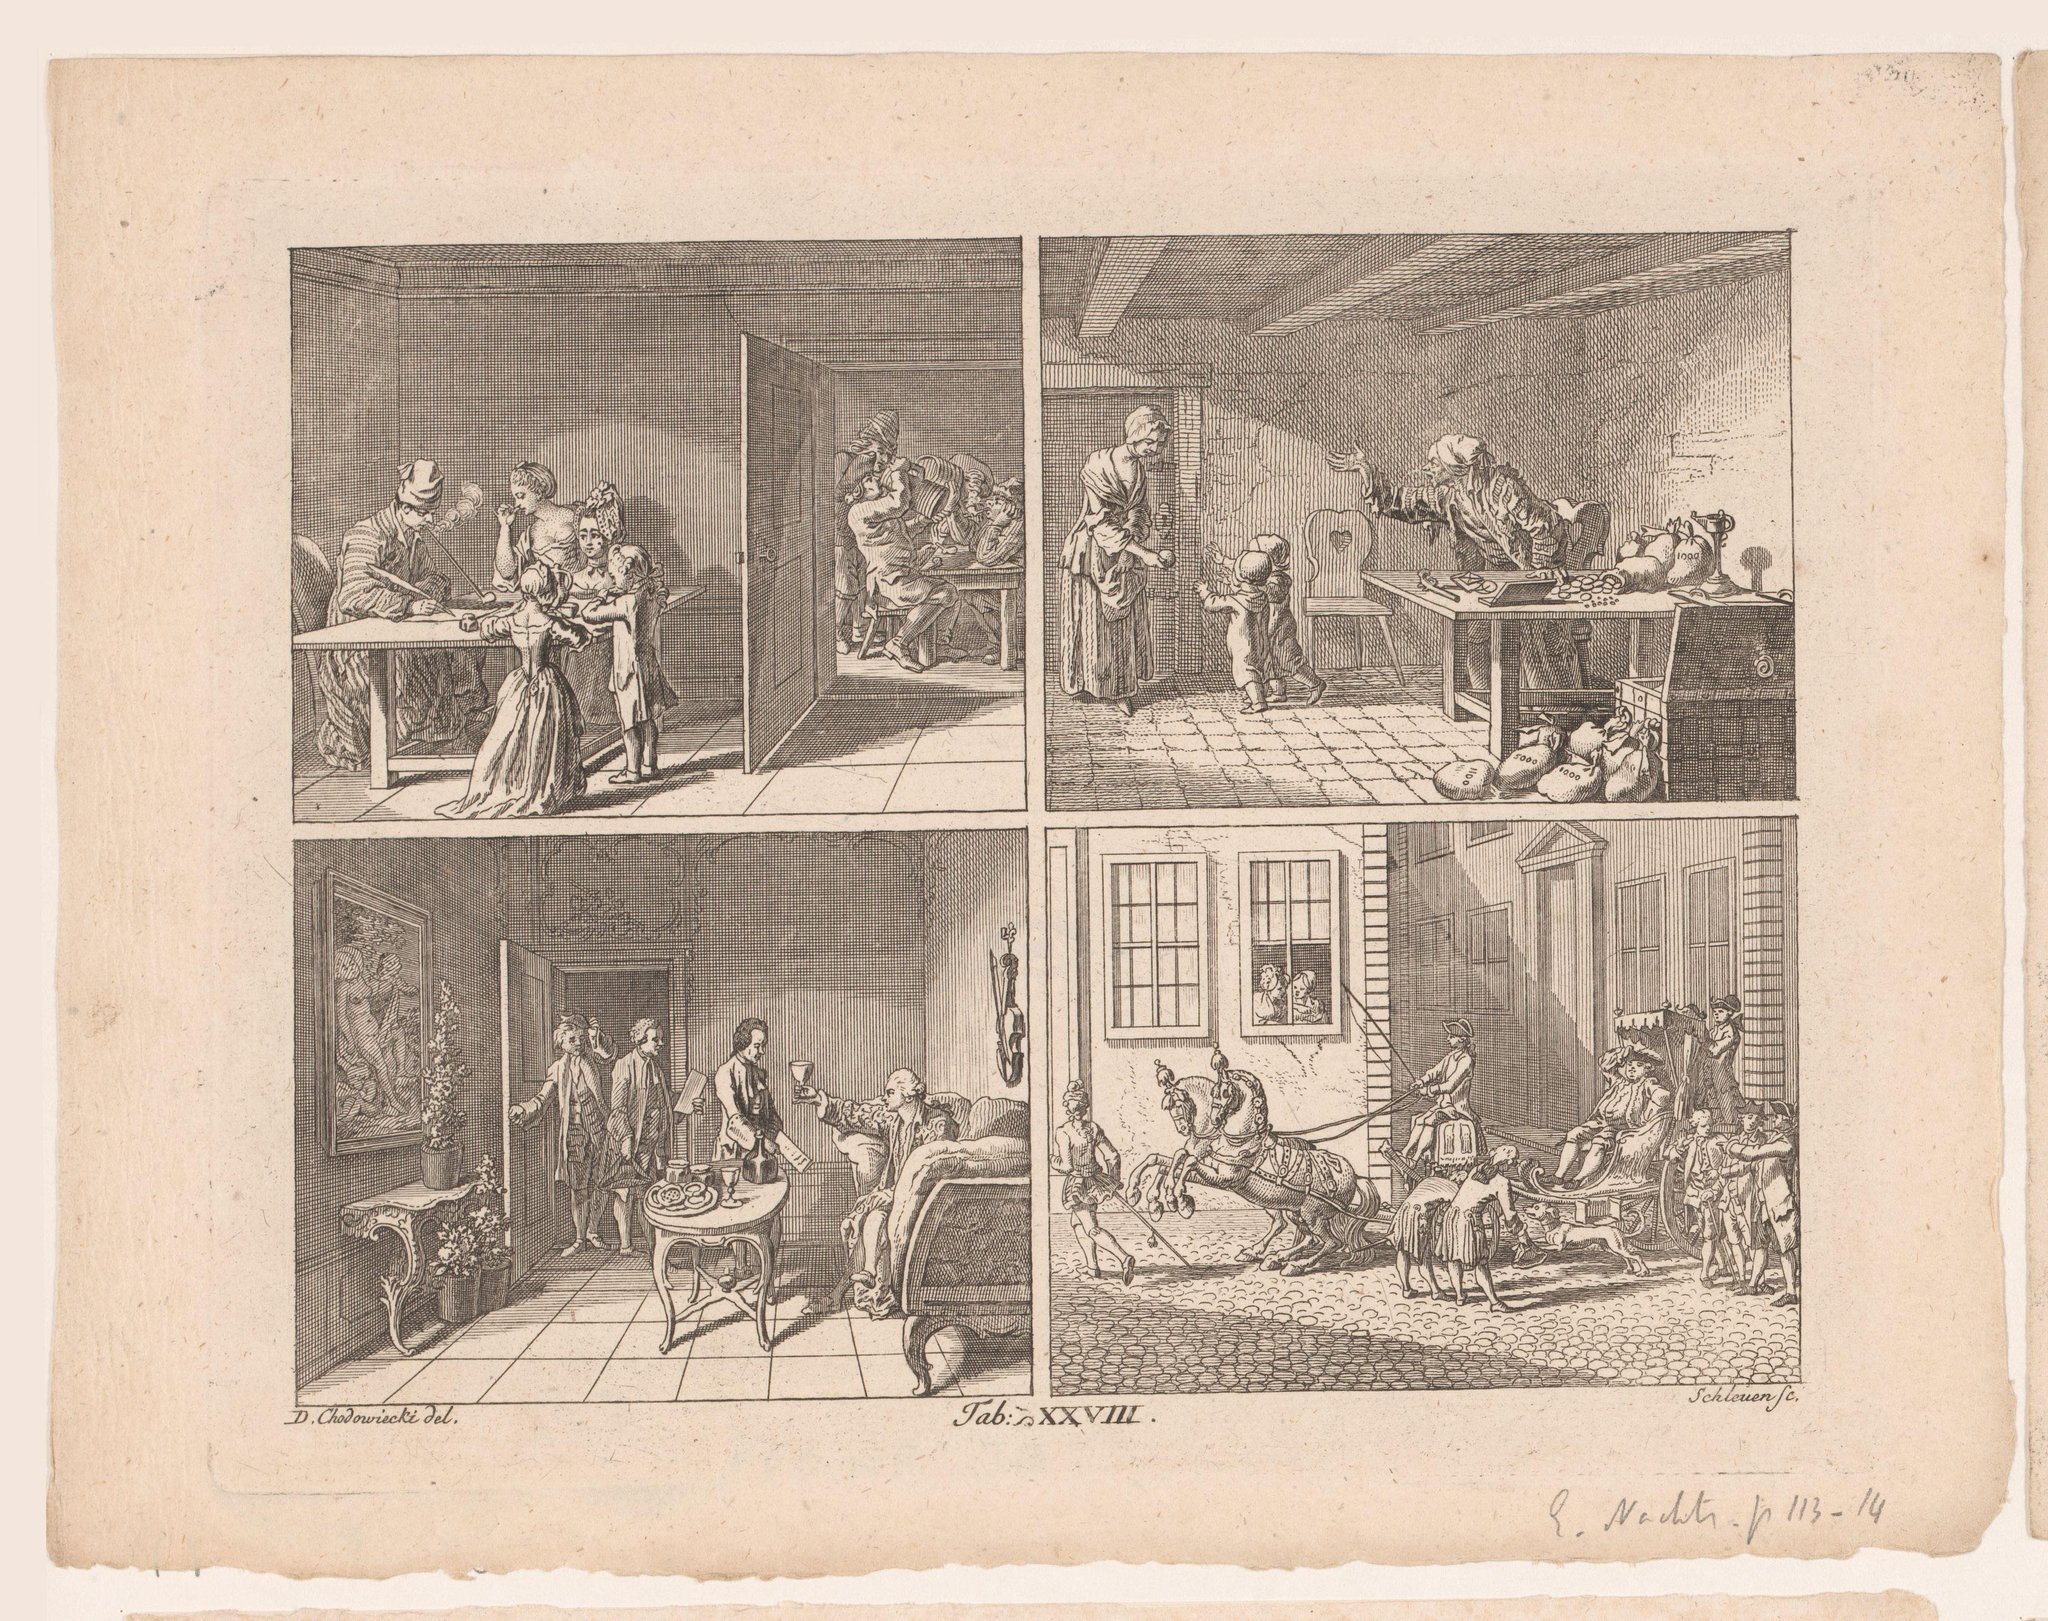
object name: print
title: Vier encyclopedische voorstellingen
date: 1765-1806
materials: paper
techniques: etching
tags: trade, commerce and finance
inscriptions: collector's mark: Lugt 2228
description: Prent ook gebruikt in: Allgemeine deutsche Bibliothek. Berlijn en Stettin: Friedrich Nicolai, 1765-1806.